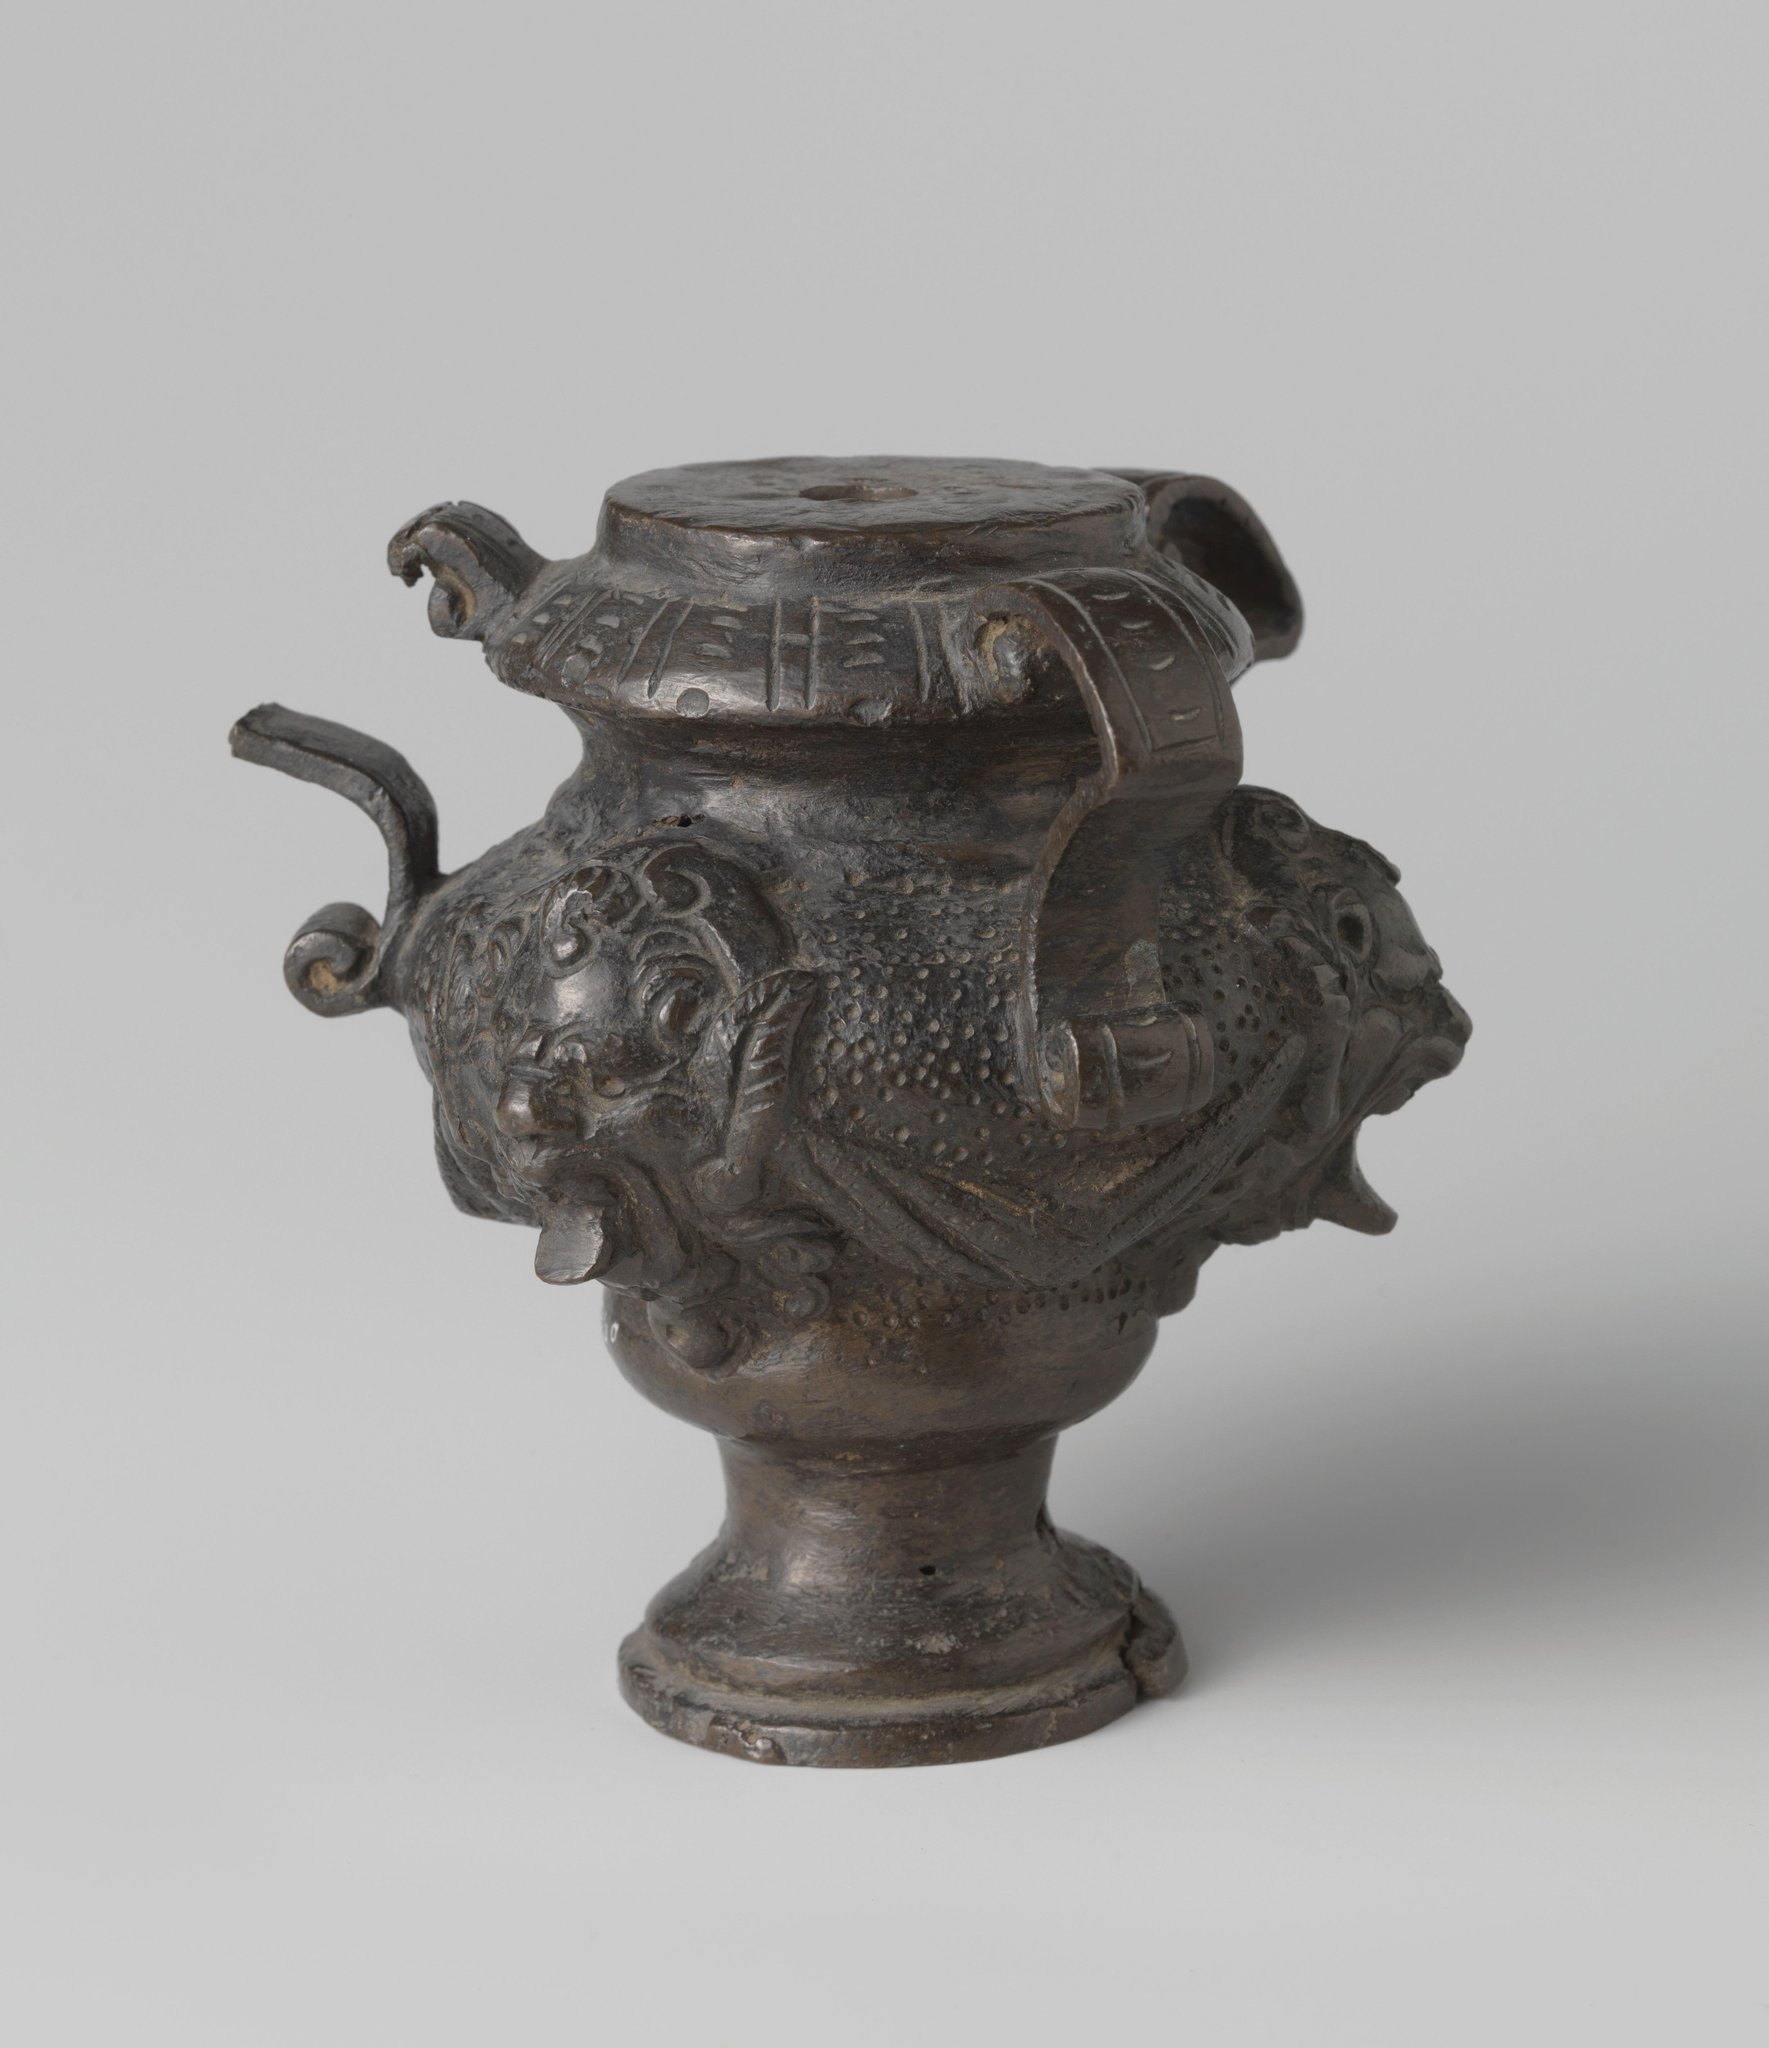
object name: sculpture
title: Vaasvormig onderdeel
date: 1575-1600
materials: bronze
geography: venice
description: Op de buik, die gezand is, drie leeuwekoppen, onderling verbonden door drie 'doekguirlandes'. Hierboven drie oren, gevormd uit geknakte, bandvormige S-voluten.